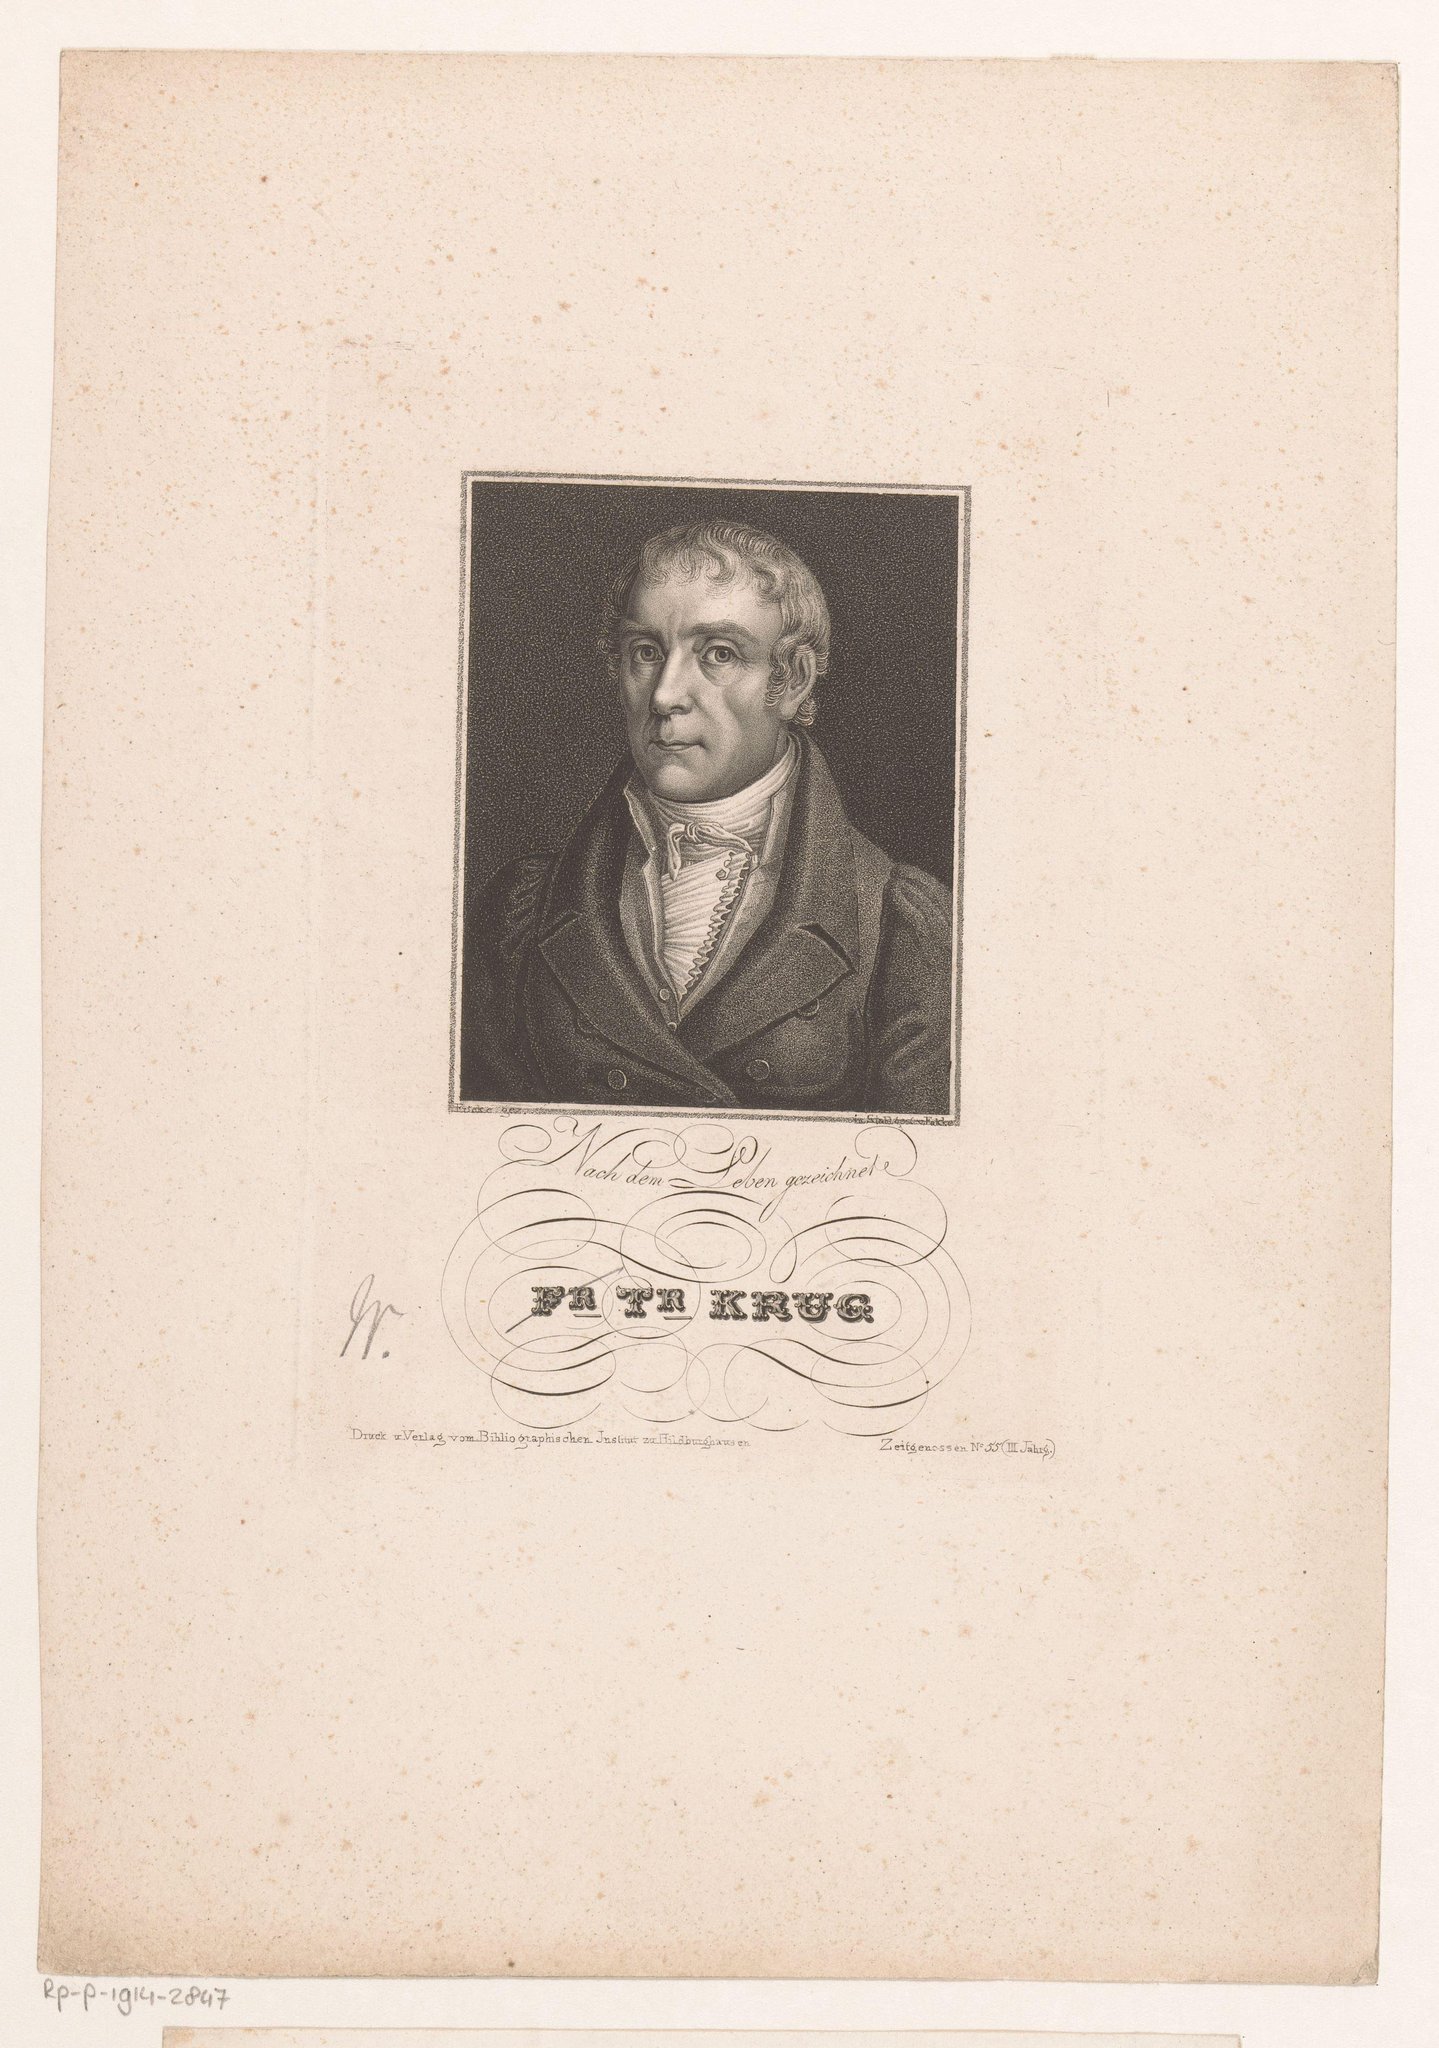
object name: print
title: Tijdgenoten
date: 1829-1840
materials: paper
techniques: engraving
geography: hildburghausen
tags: historical persons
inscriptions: collector's mark: Lugt 2228